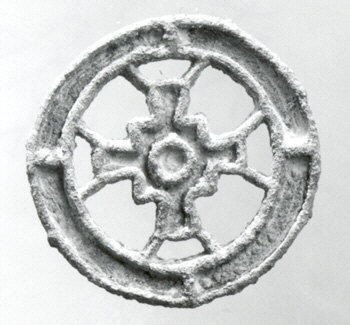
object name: stamp seal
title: Compartmented stamp seal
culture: bactria-margiana archaeological complex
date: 2333-1668 BCE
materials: copper alloy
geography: bactria-margiana